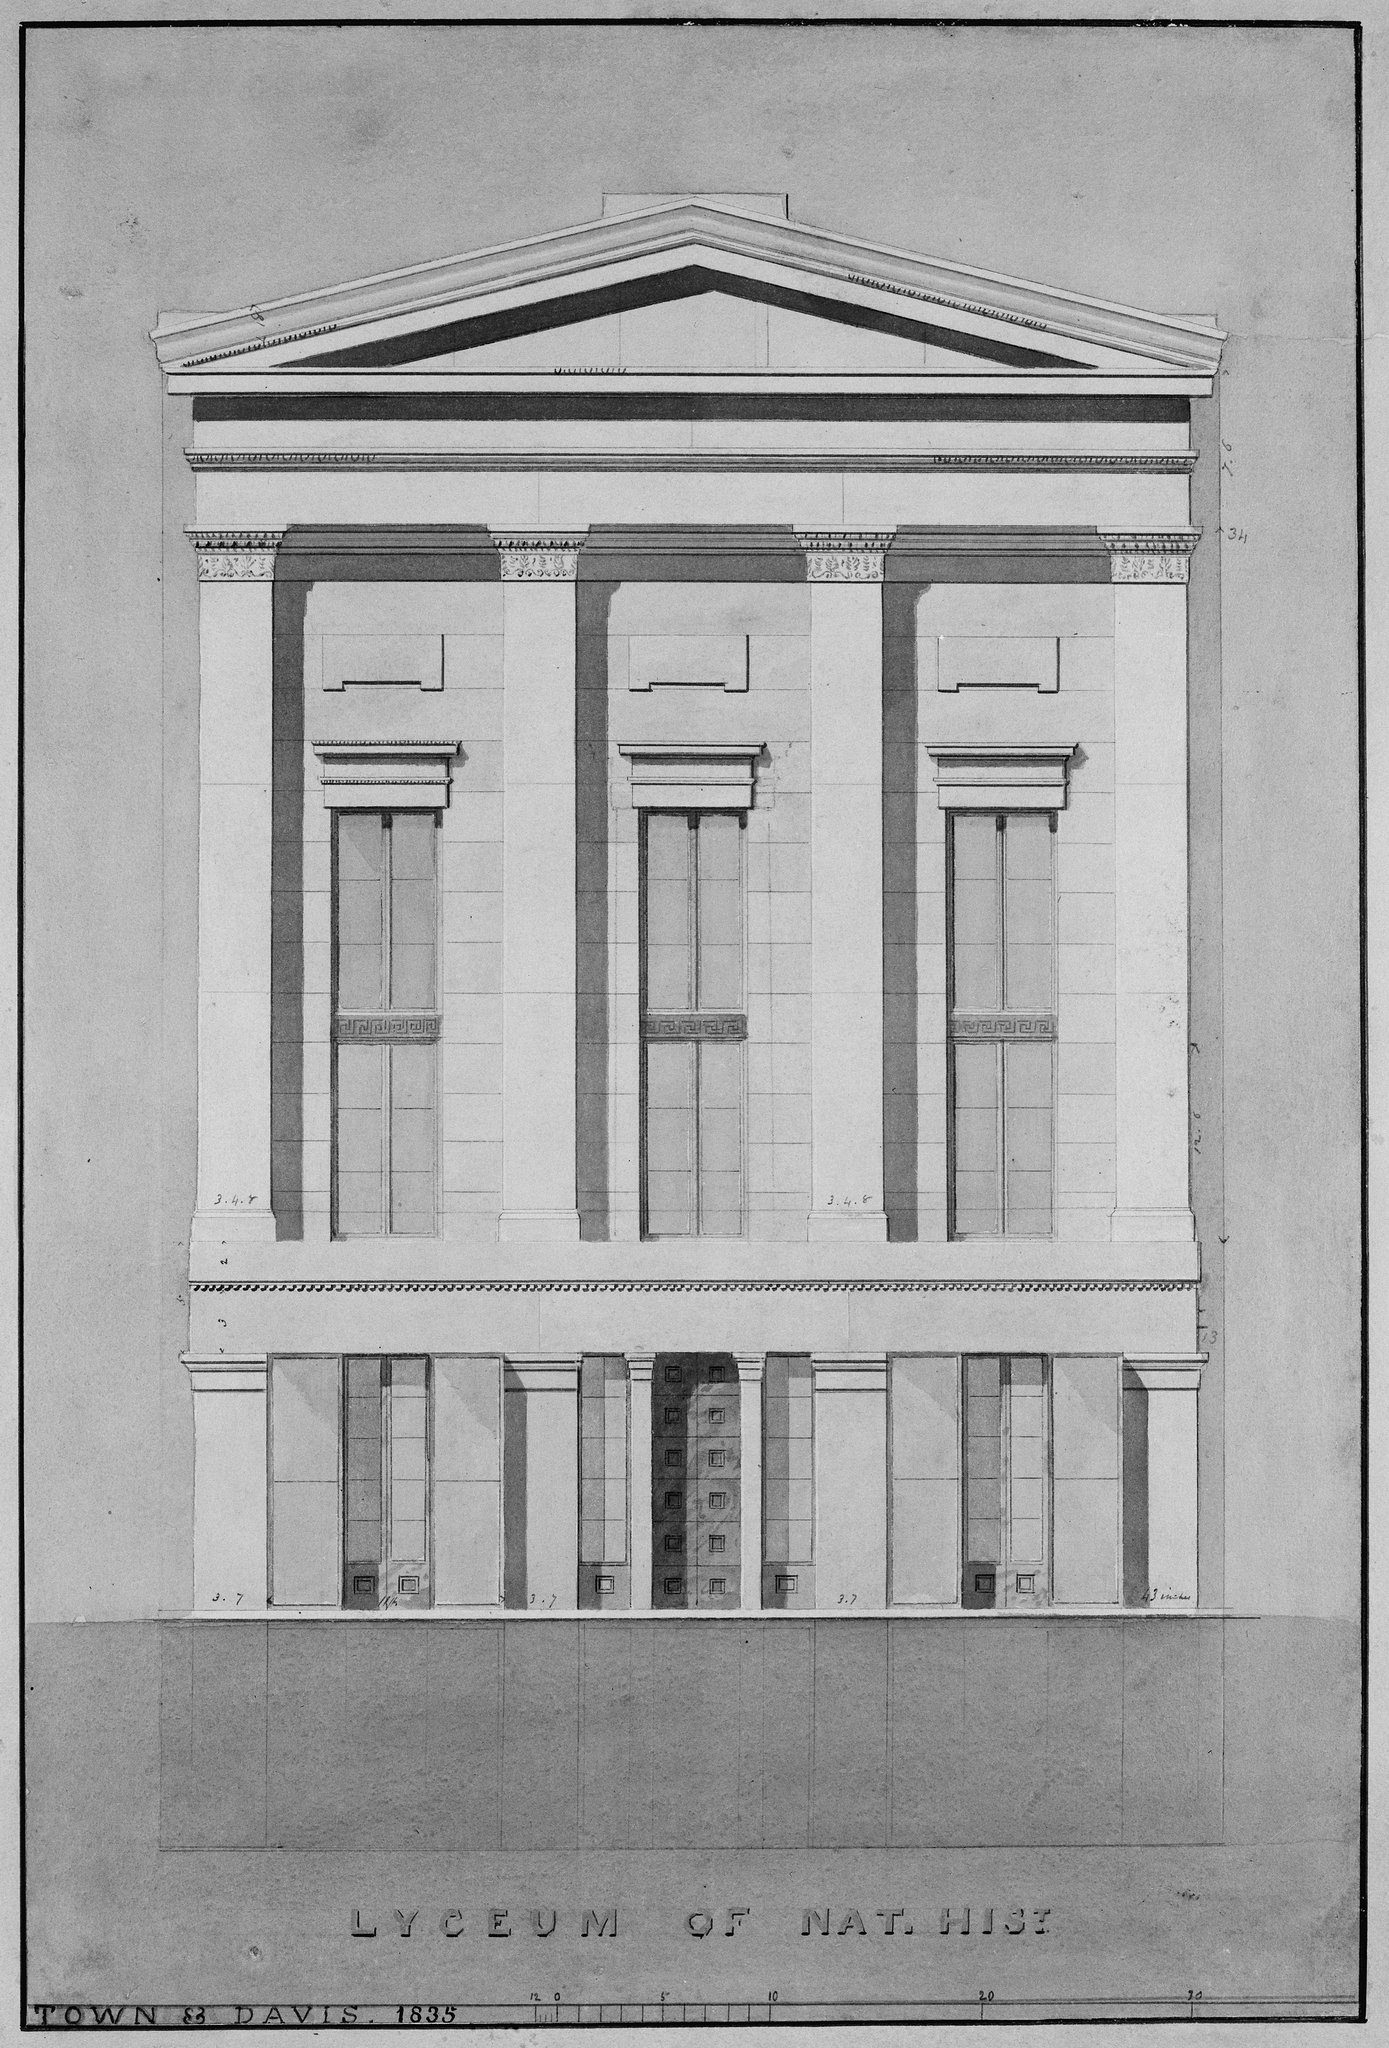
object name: drawing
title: Lyceum of Natural History, New York (front elevation)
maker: alexander jackson davis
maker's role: artist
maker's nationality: american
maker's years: 1803-1892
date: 1835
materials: graphite, ink, watercolor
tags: architecture,buildings